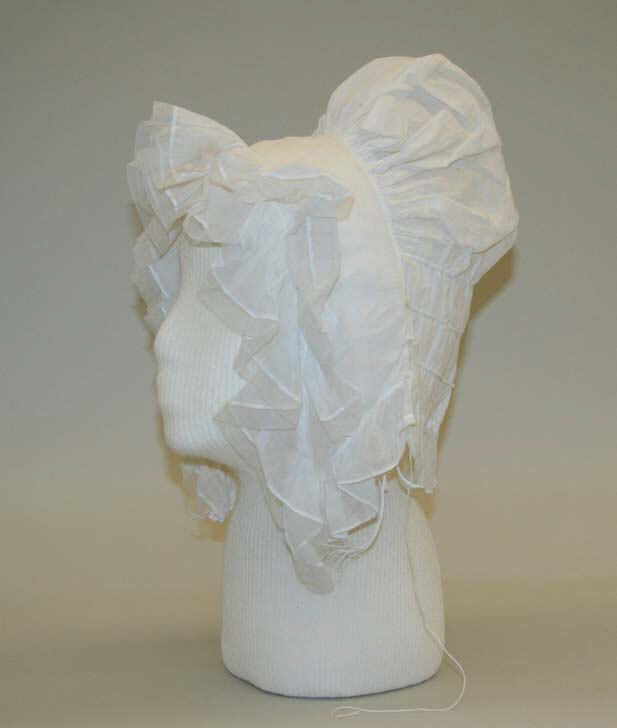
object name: cap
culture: british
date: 1830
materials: cotton